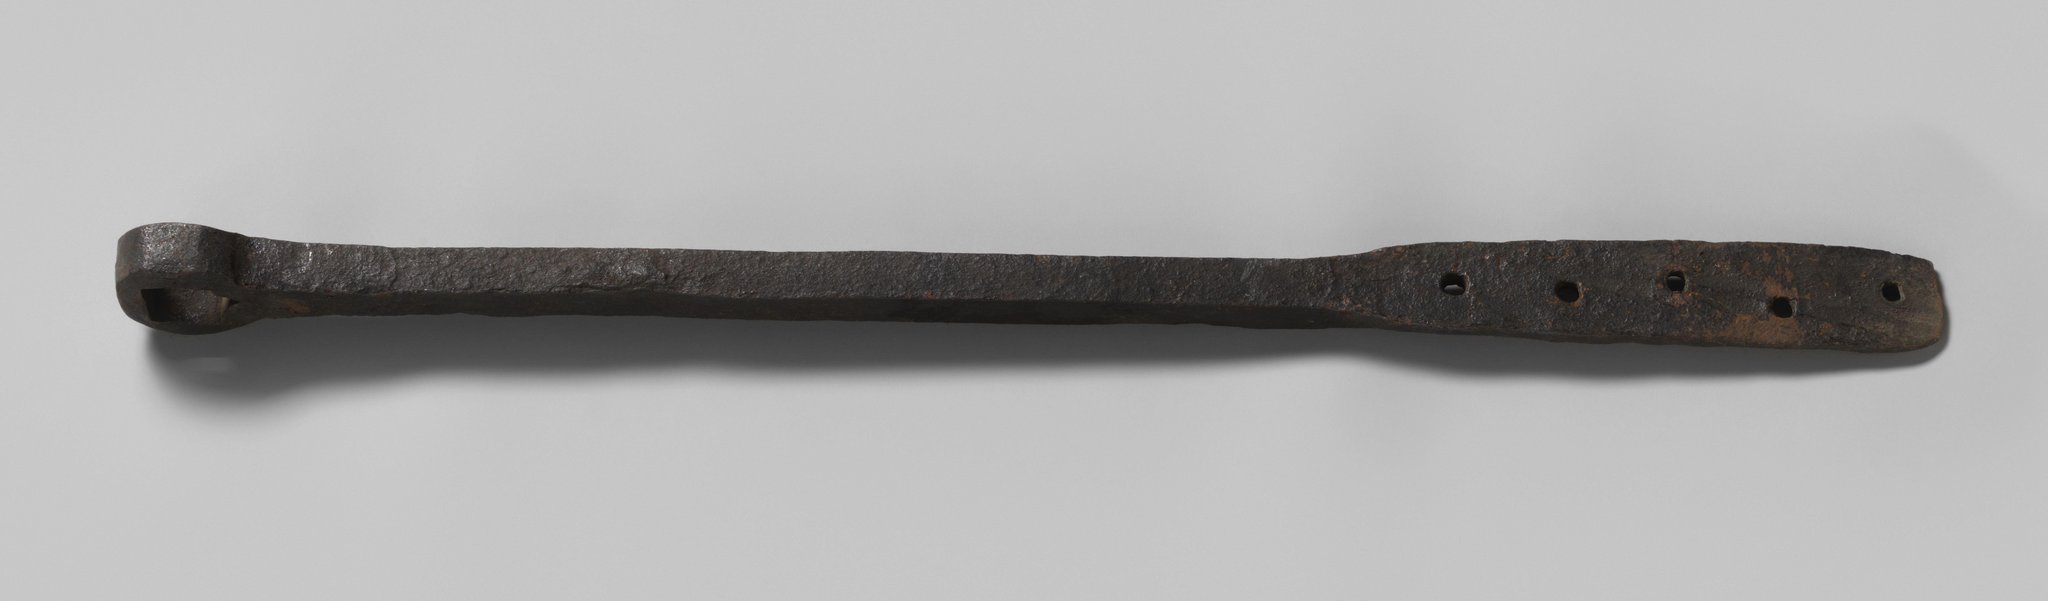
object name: feather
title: Veer en schieter behorend bij een muuranker van het Gelderse Spijker te Arnhem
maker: Anonymous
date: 1500-1600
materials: iron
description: Veer en schieter behorend bij een muuranker, afkomstig van het Gelderse Spijker te Arnhem. gesloopt in 1880.